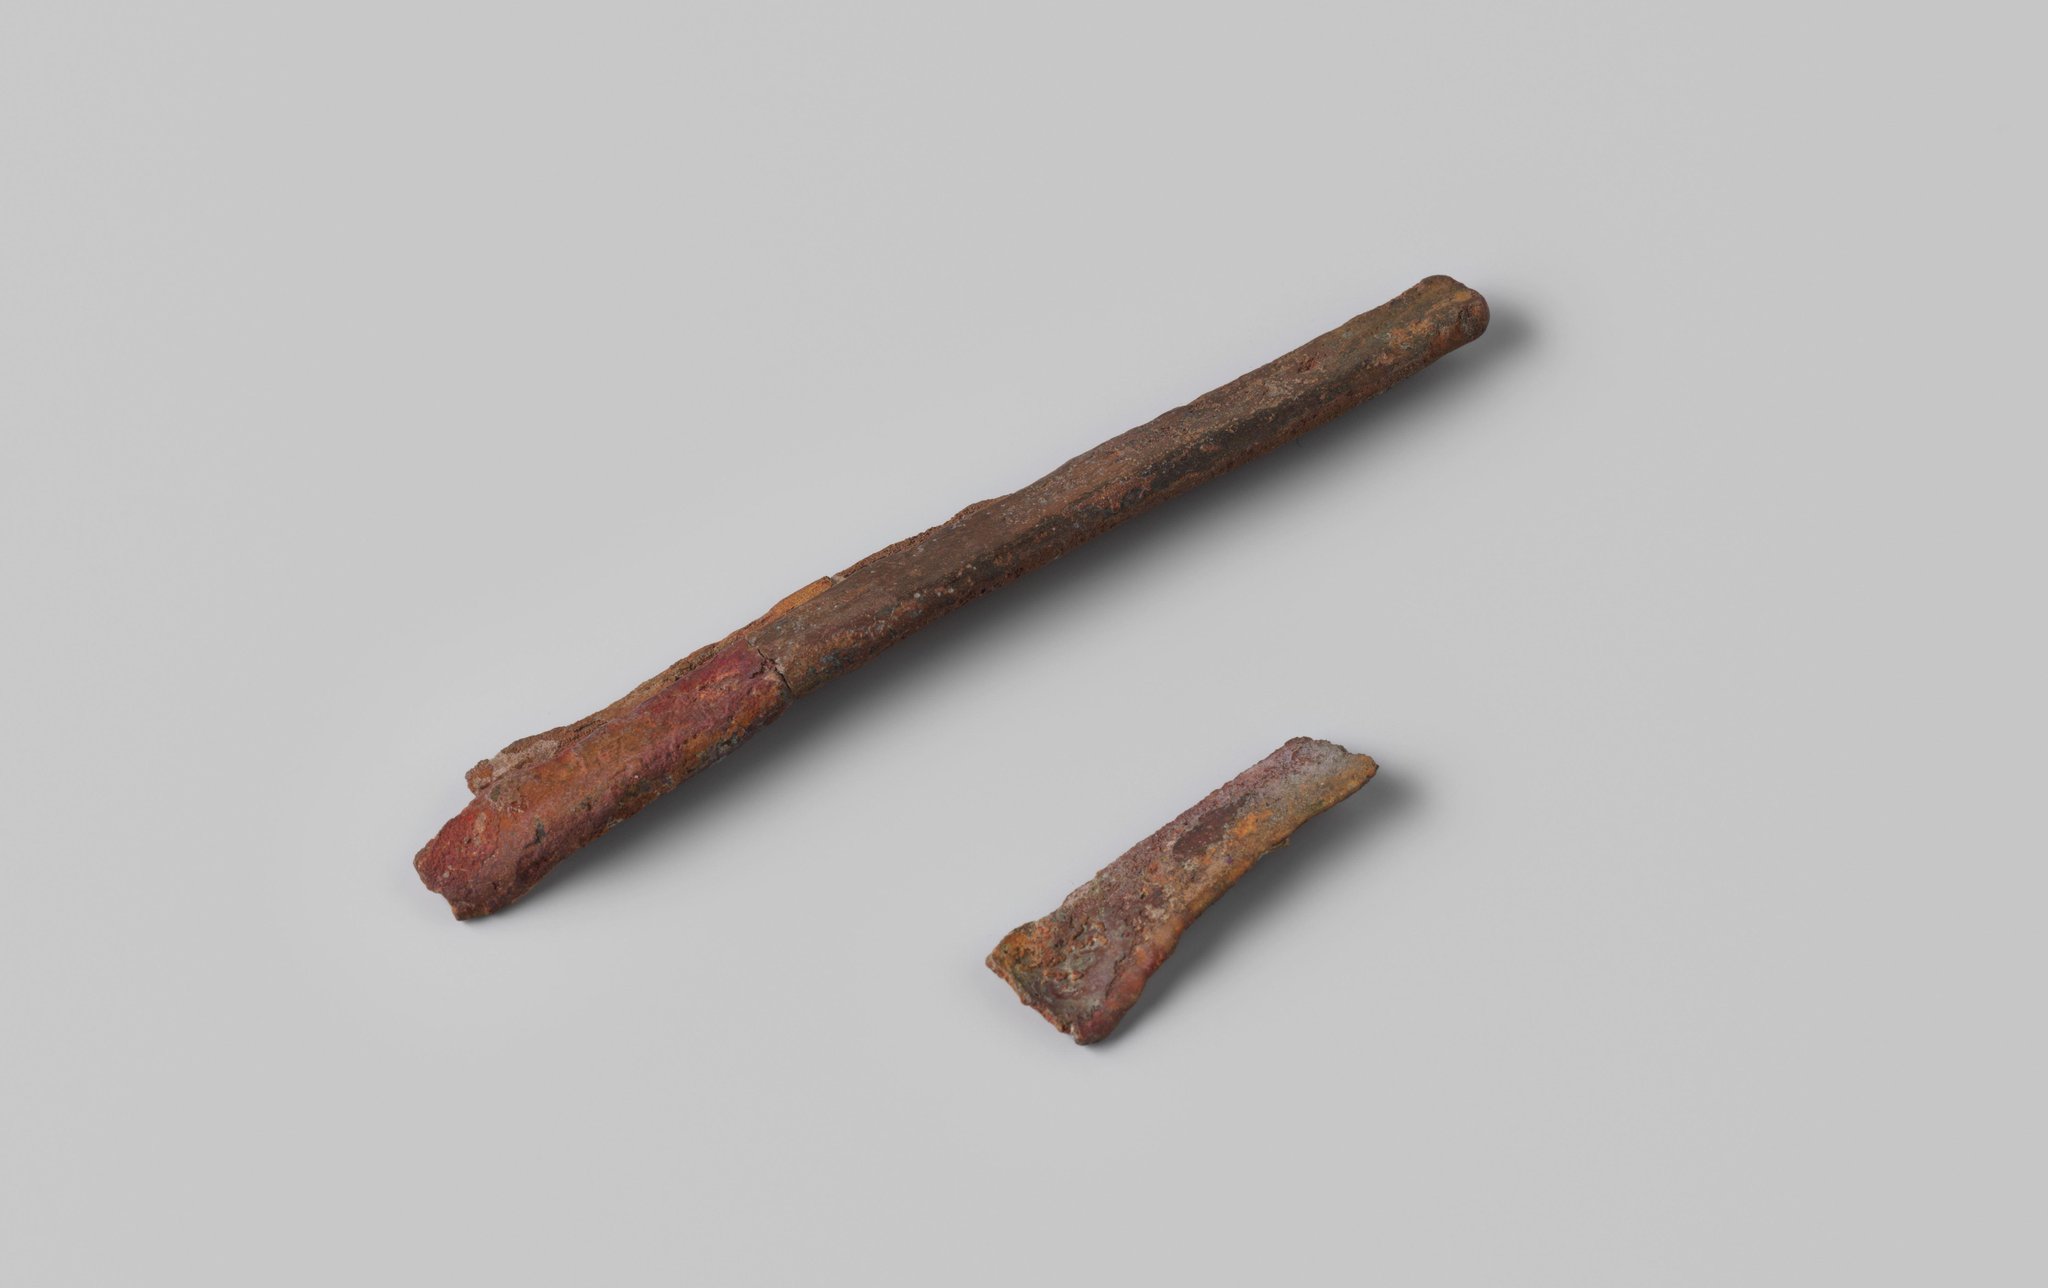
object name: fragment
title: Fragmenten van koper uit het wrak van de Oost-Indiëvaarder Hollandia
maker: Anonymous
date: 1700-1743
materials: copper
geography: netherlands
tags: verenigde oostindische compagnie, hollandia (schip), annet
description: Varied parts or fragments, strips and strip-shaped fragments; fragm.